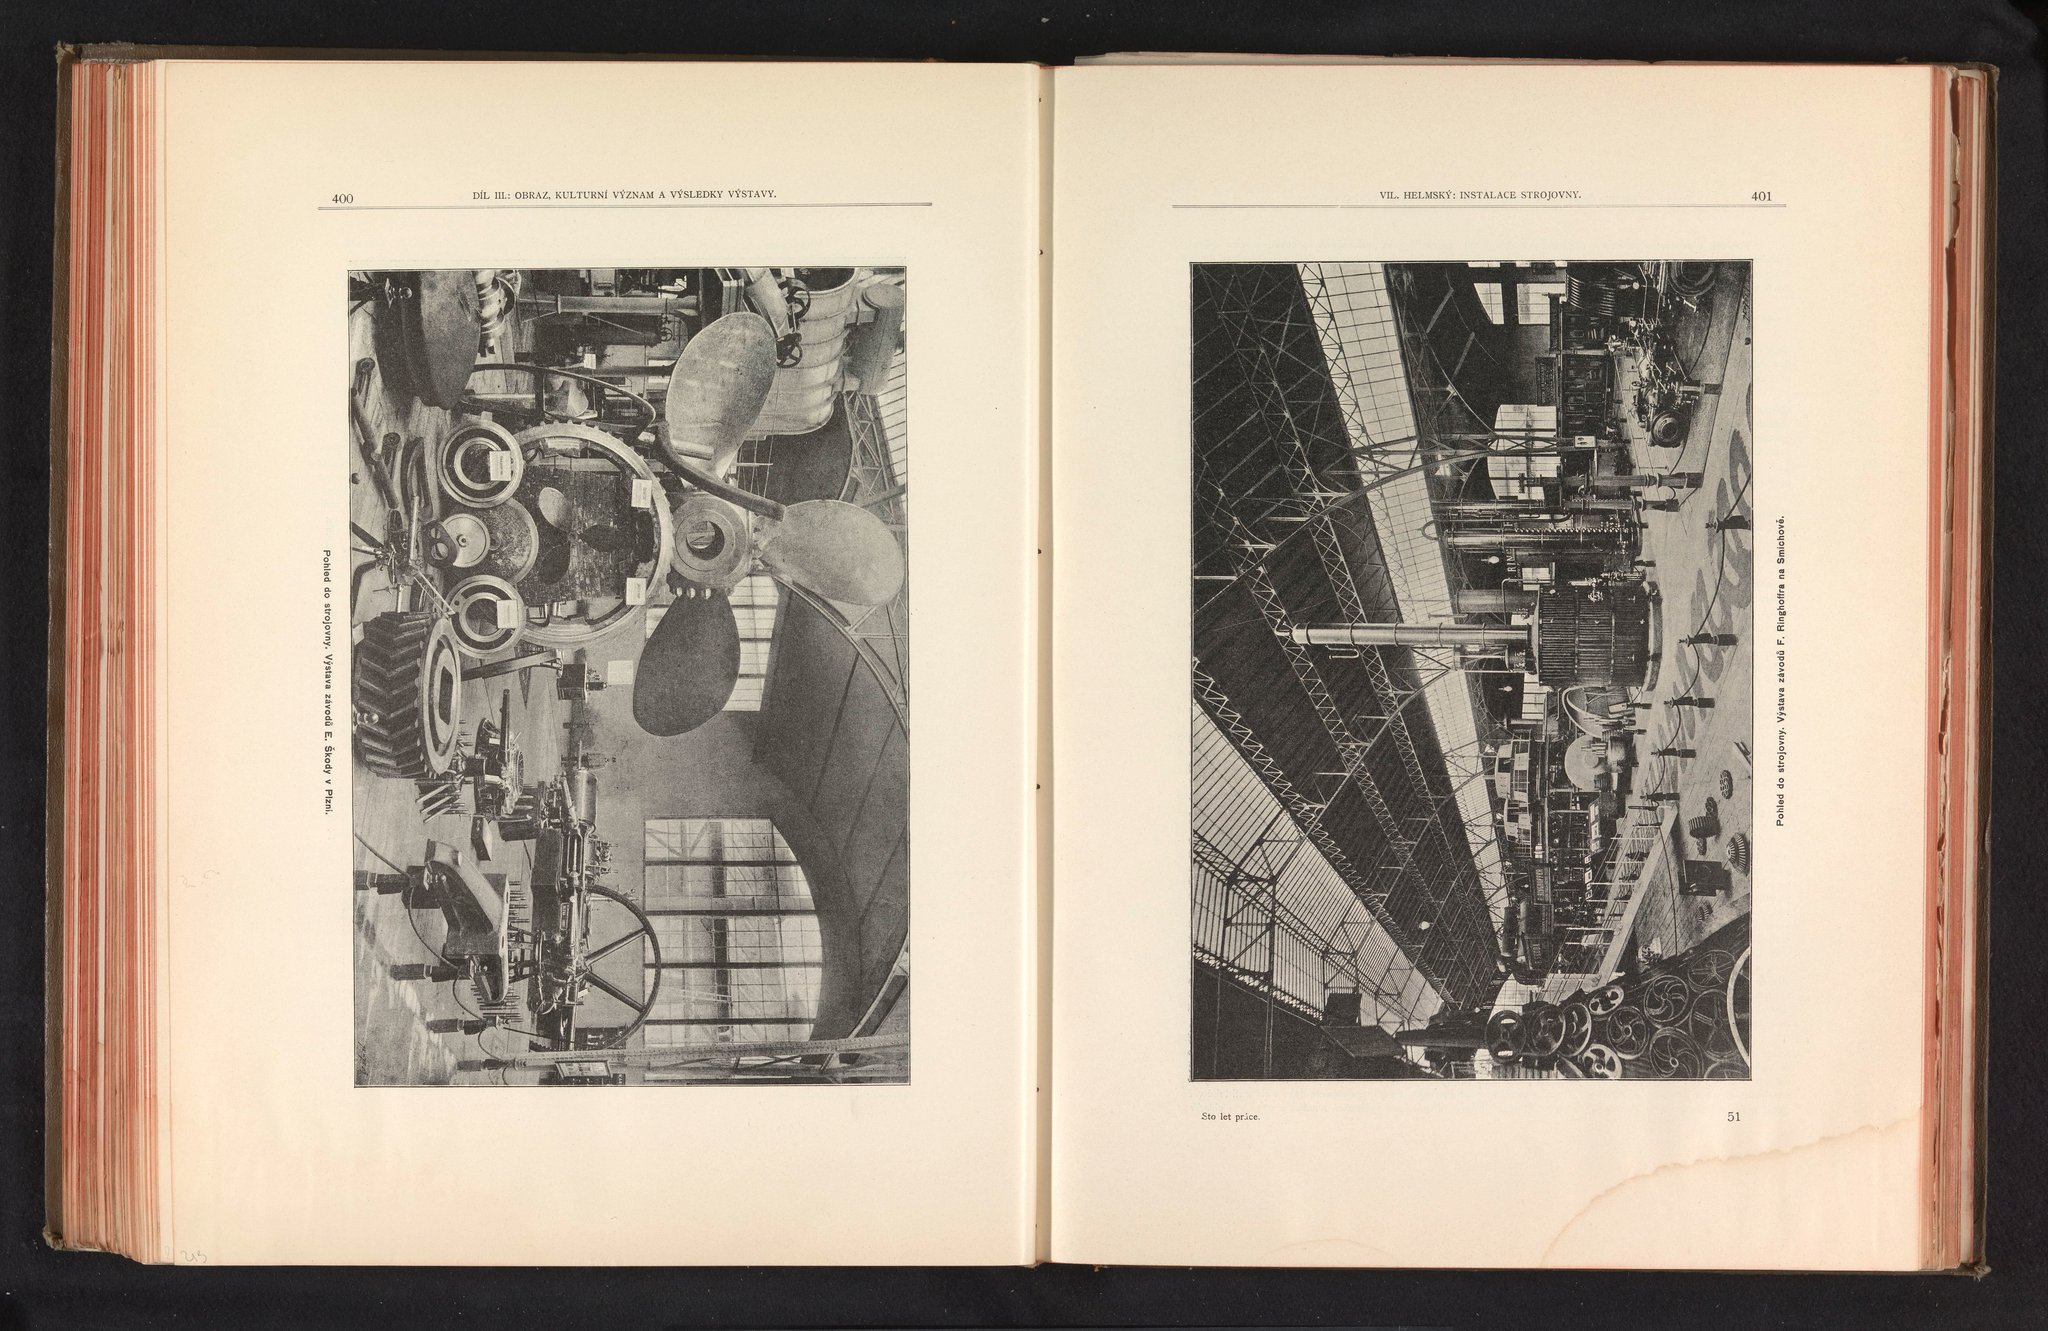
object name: page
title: Interieur van een machinekamer met een tentoonstelling van Skoda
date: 1890-1895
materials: paper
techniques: autotype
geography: prague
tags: machines; parts of machines; tools and appliances, interior ~ representation of a building